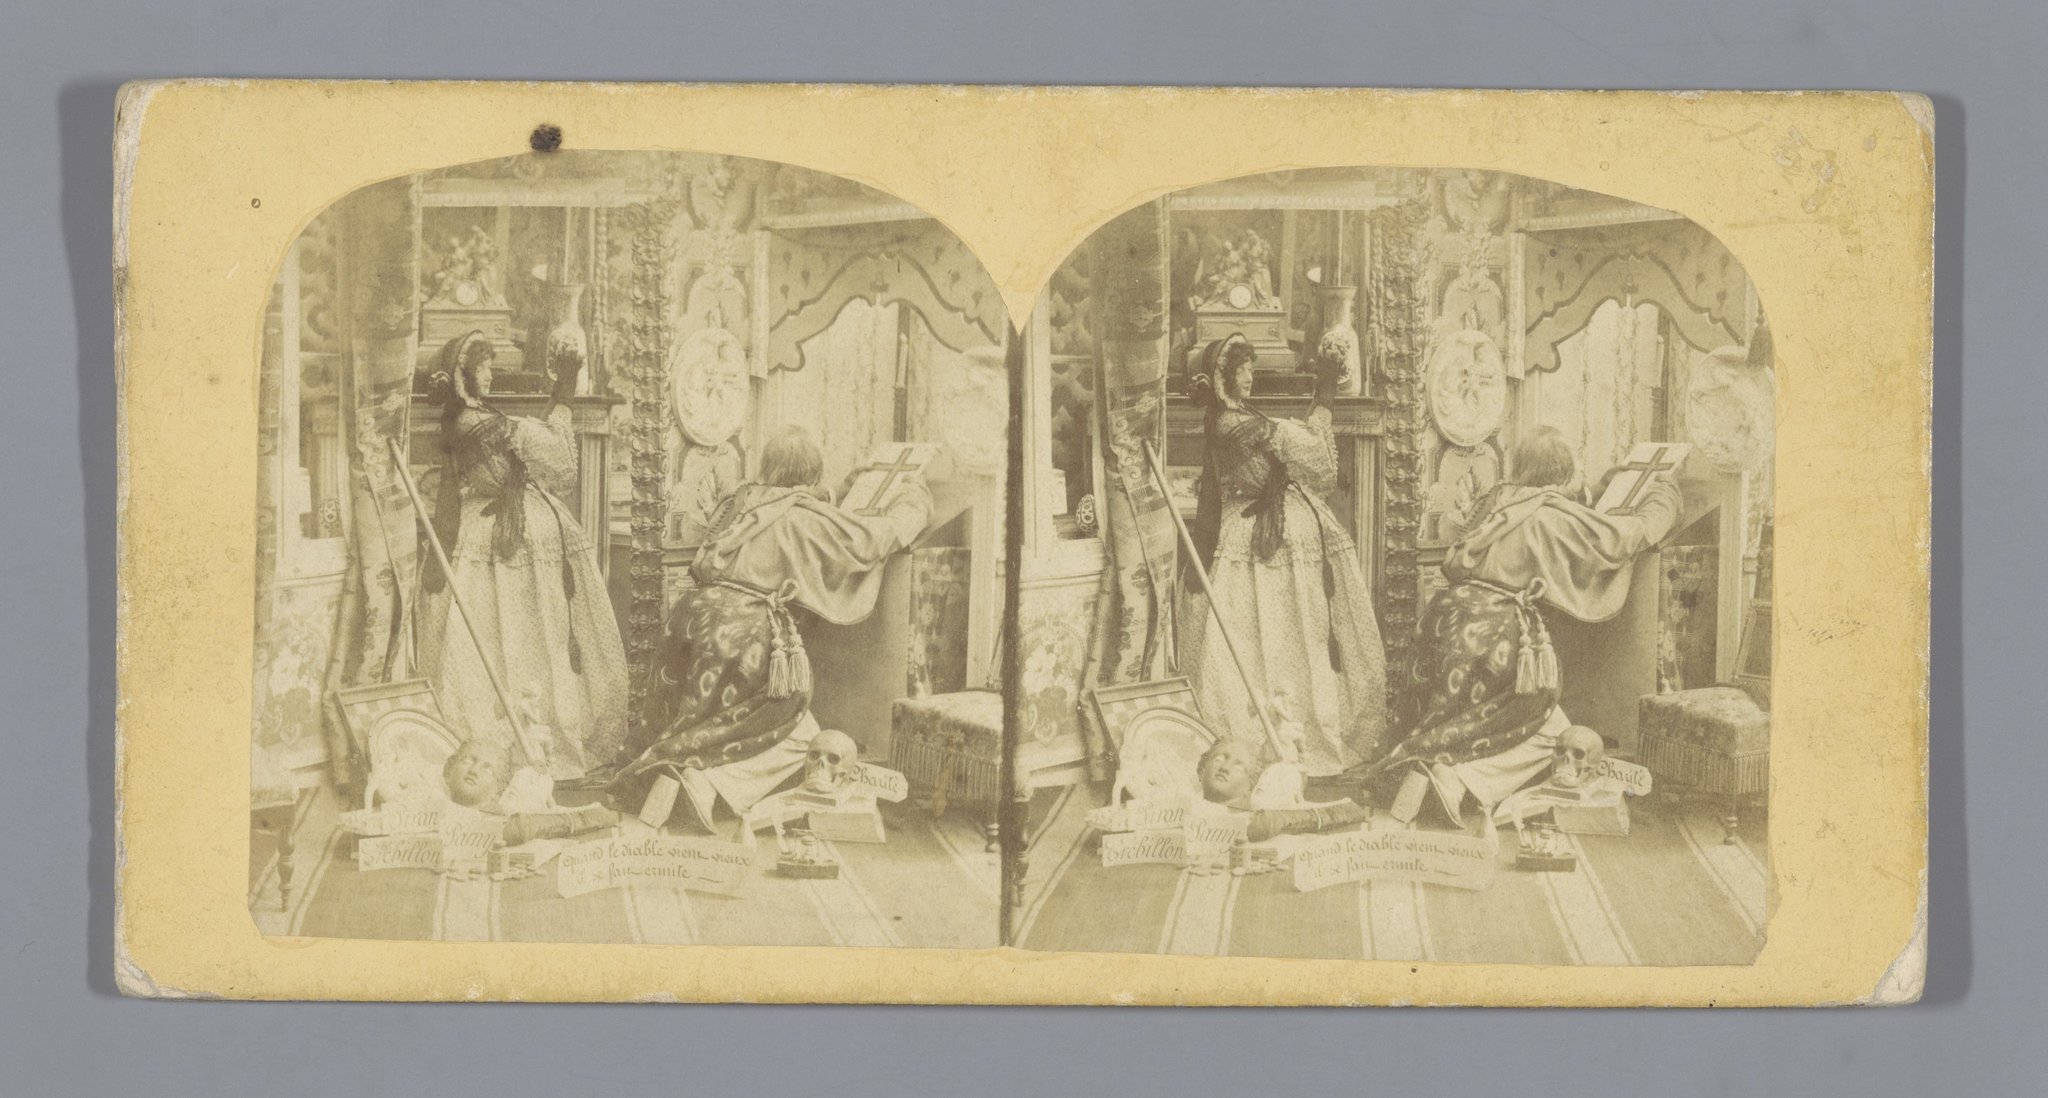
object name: stereograph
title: Theatrale opstelling van een man in een christelijk gewaad en een vrouw met daarvoor attributen zoals schedels en boeken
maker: Anonymous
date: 1850-1880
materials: cardboard, photographic support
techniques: albumen print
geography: europe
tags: 'tableau vivant', death's head, skull (symbol of death), europe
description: Voor de attributen staan borden met de tekst: Piron, Parny, Crebillon. Quand le diable vient vieux il se fait ermite Charité.